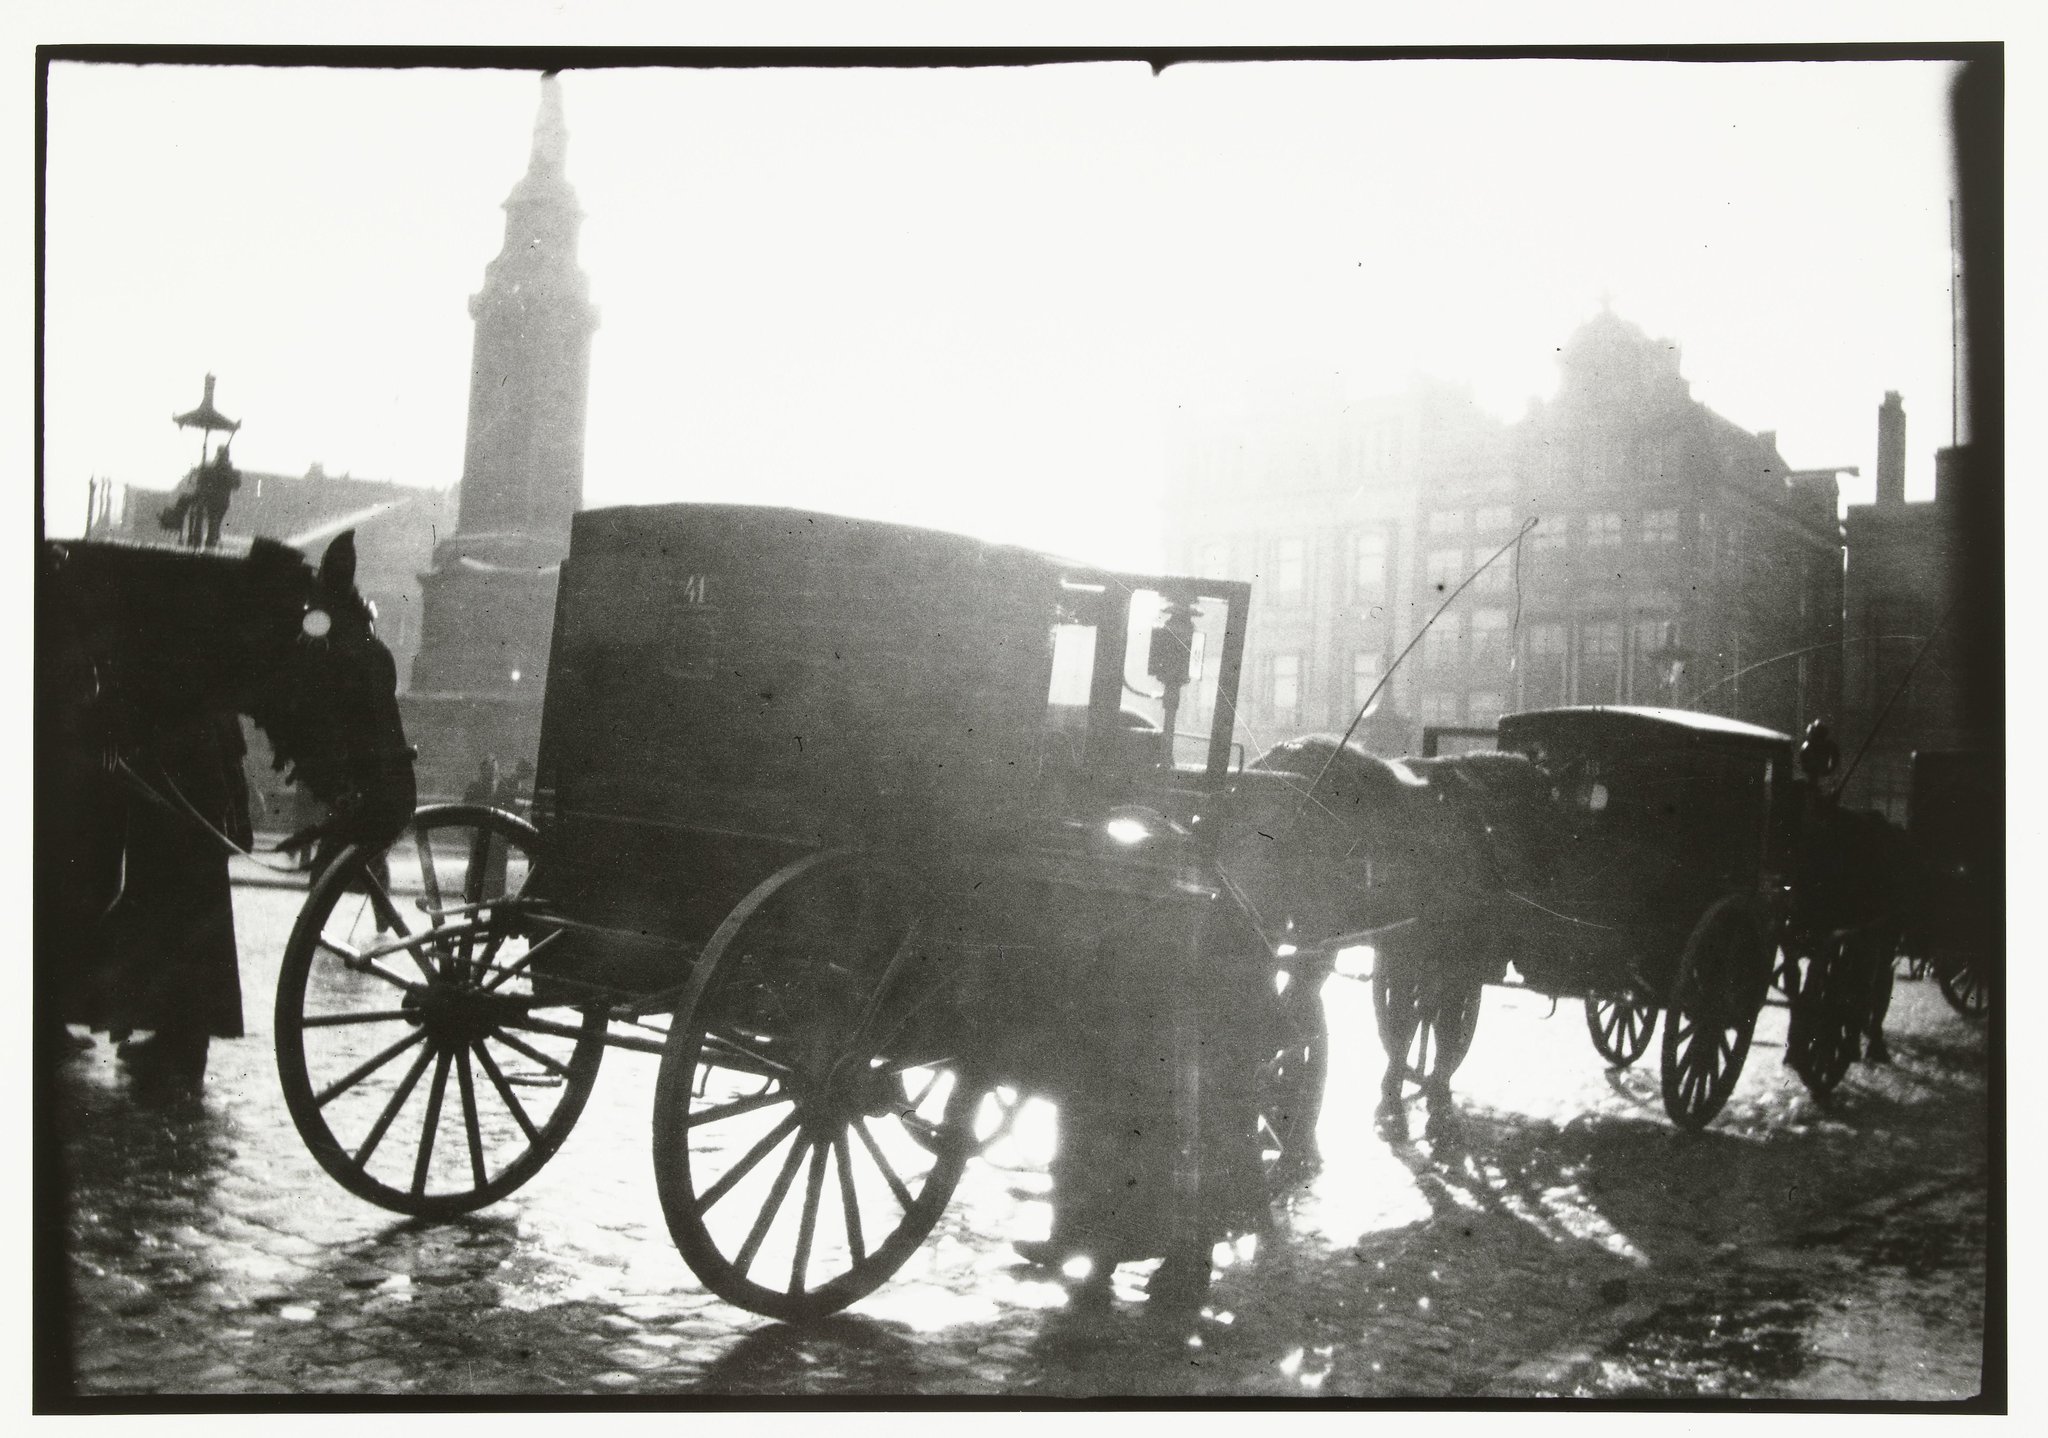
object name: photograph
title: Rijtuigen op de Dam in Amsterdam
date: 1890-1910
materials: paper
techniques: gelatin silver print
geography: netherlands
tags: dam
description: Op de achtergrond het standbeeld De eendracht of Naatje op de Dam